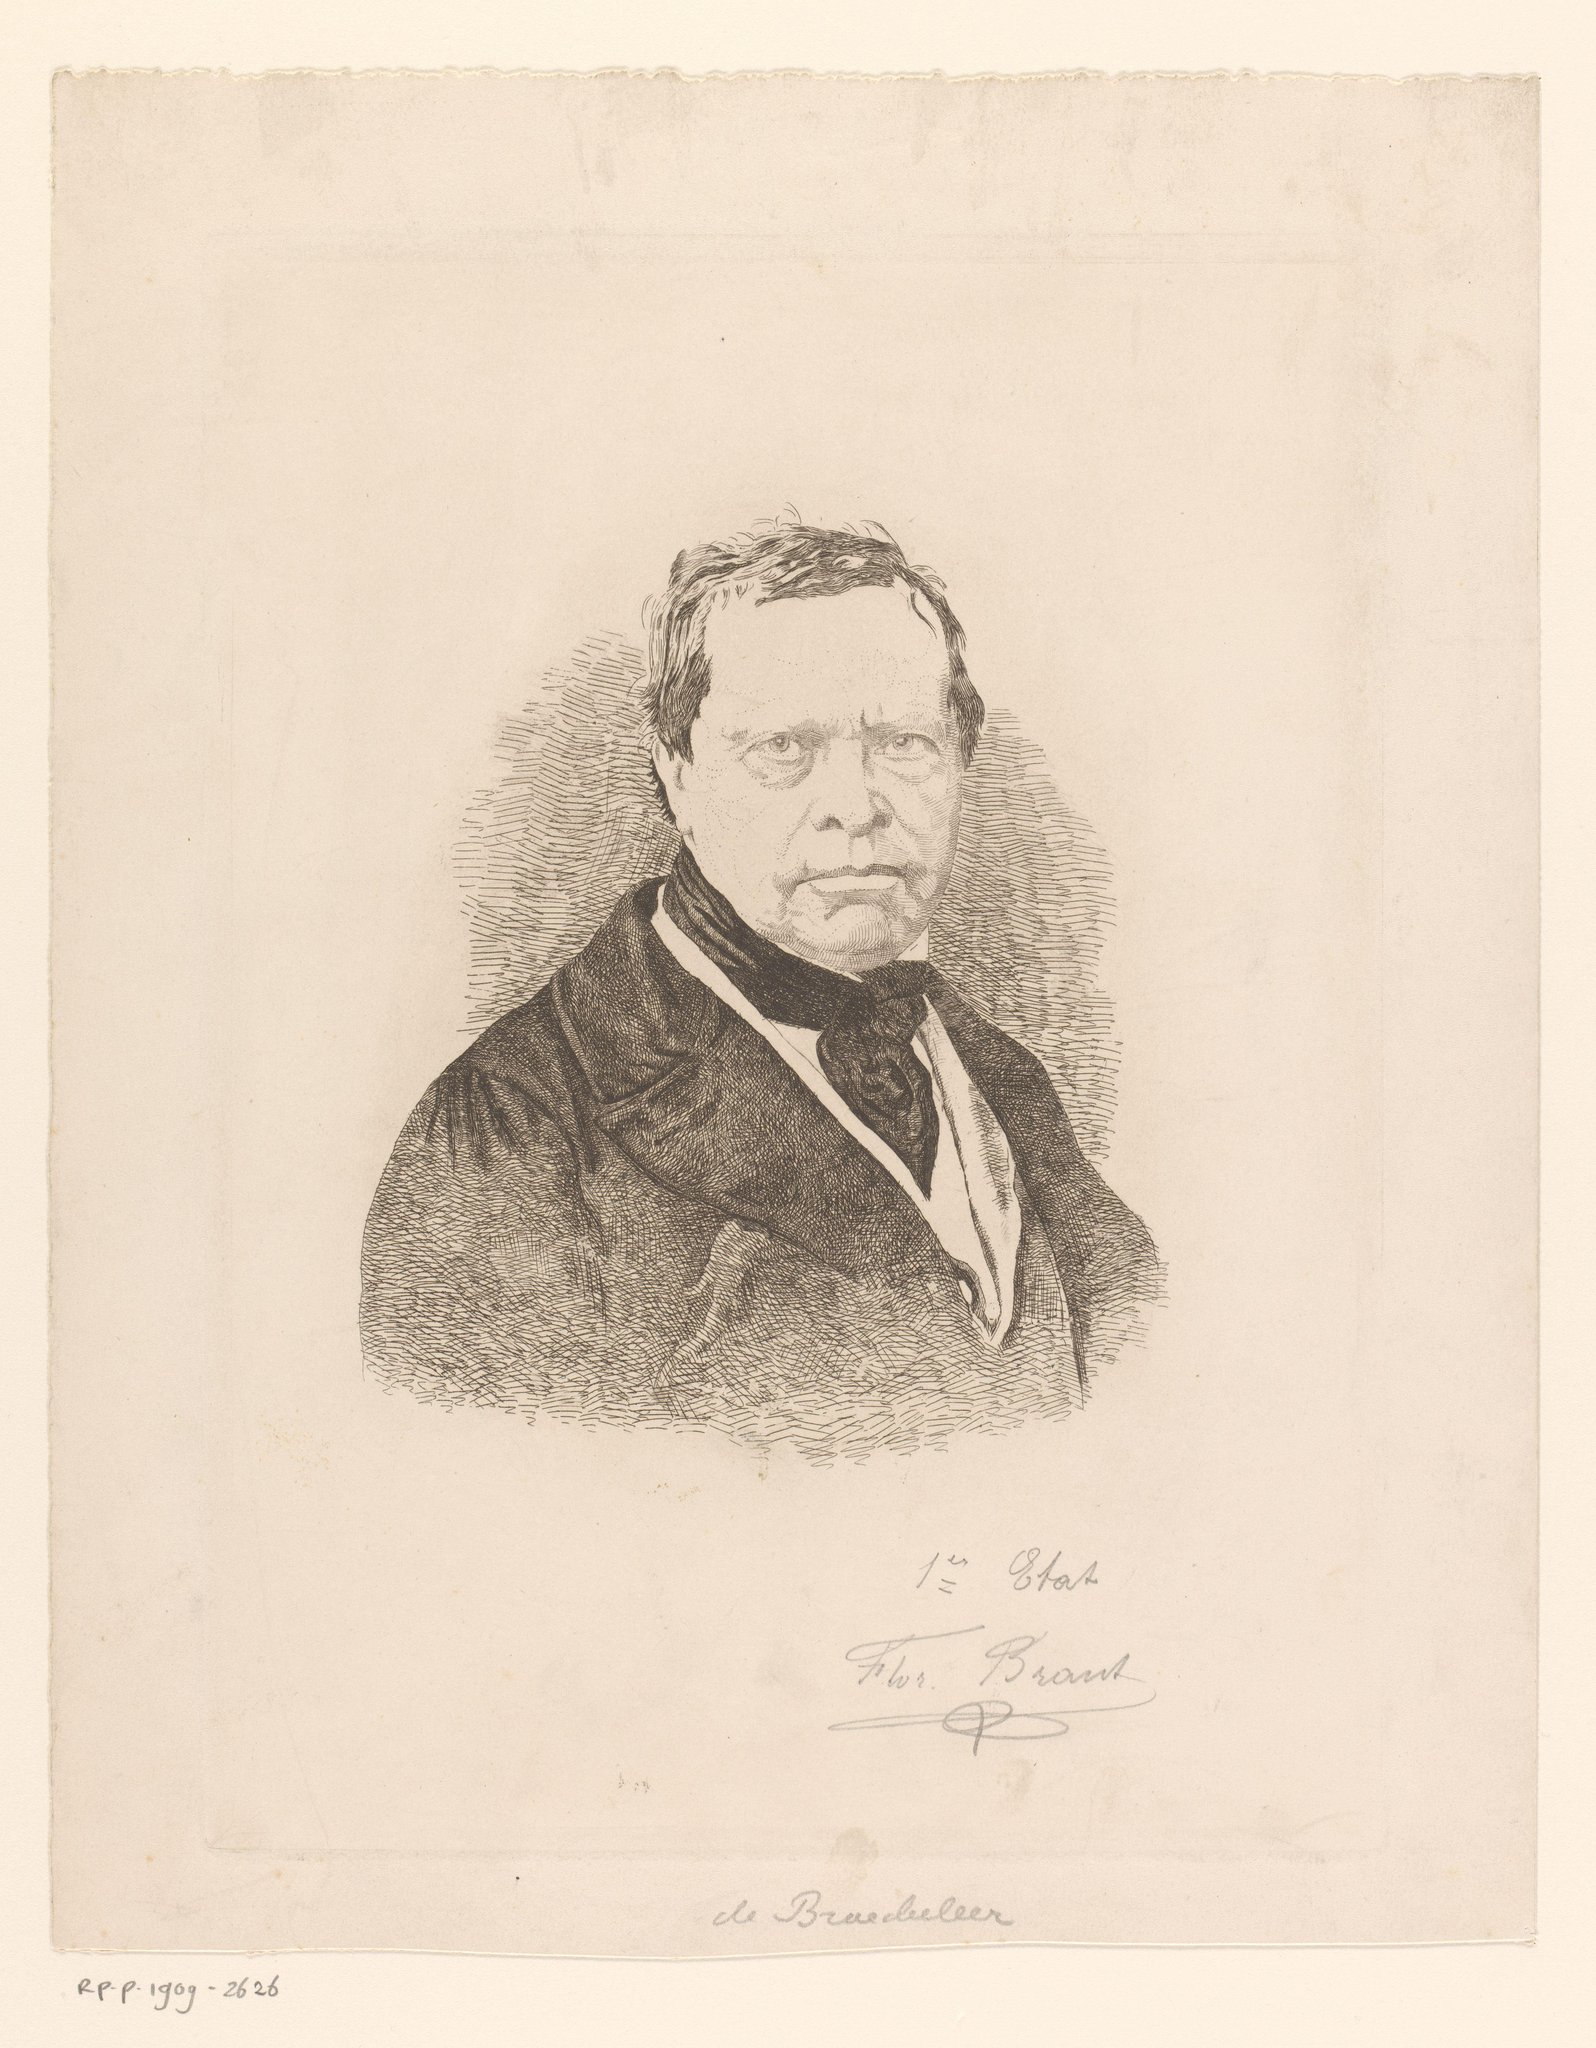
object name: print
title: Portret van Ferdinand de Braekeleer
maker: florent brant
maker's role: print maker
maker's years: 1863-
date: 1873-1909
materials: paper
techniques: etching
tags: antwerp, print maker, draughtsman, ferdinand de braekeleer (i), adult man, historical persons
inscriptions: inscription: ‘1e Etat’, collector's mark: Lugt 2228